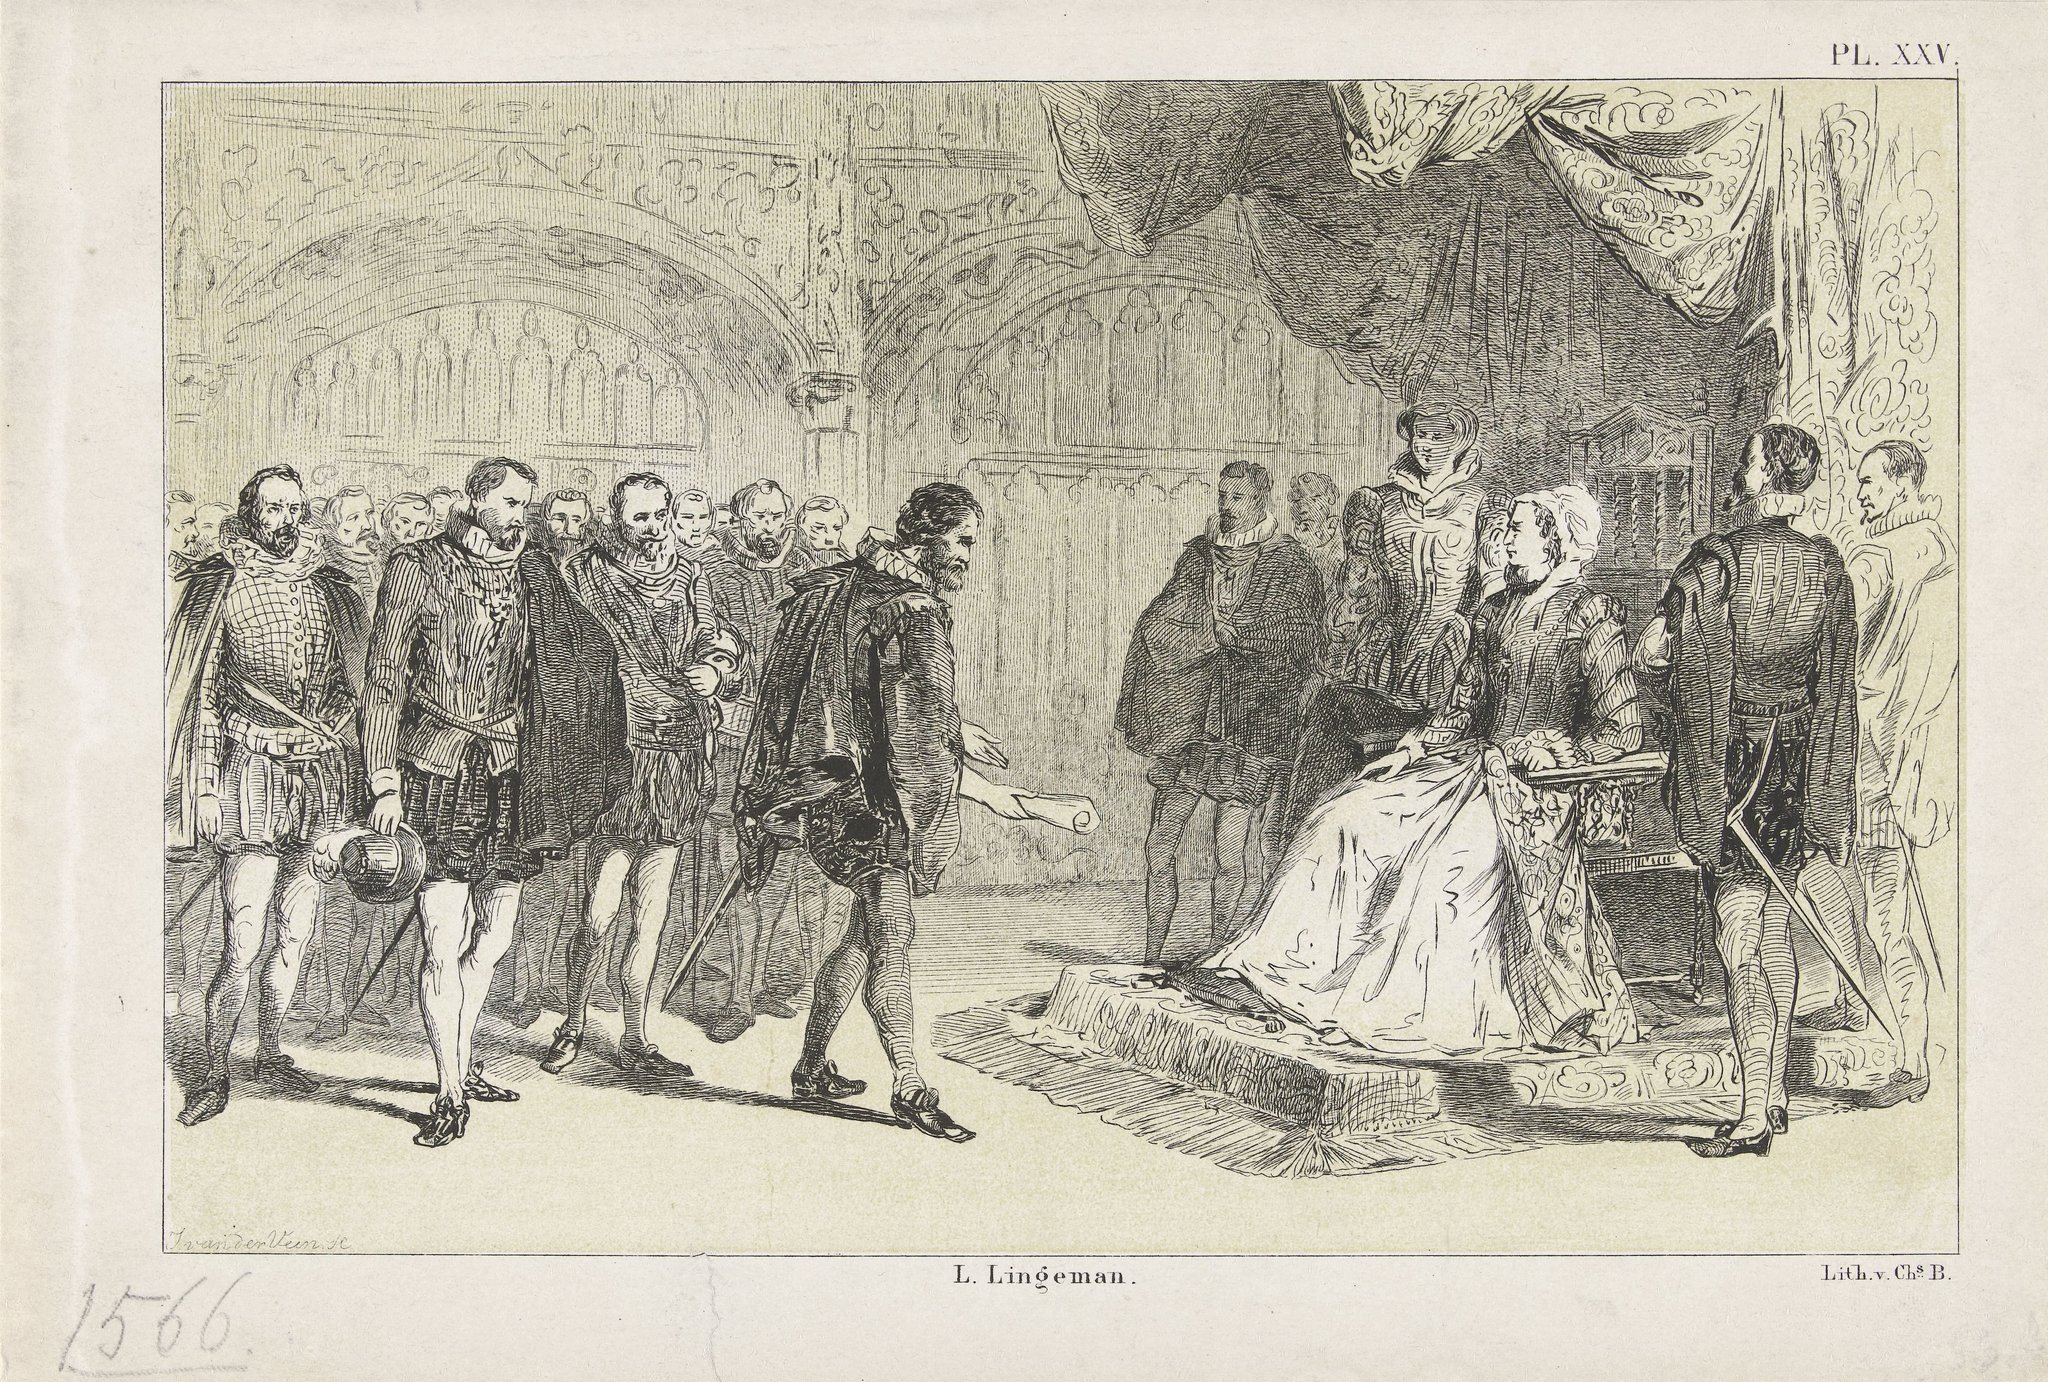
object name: print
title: Het aanbieden van het Smeekschrift aan de hertogin van Parma, 1566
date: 1853-1860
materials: paper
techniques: lithograph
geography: netherlands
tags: brussels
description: Het aanbieden van het Smeekschrift door het verbond der edelen aan de landvoogdes, de hertogin van Parma, te Brussel 5 april 1566. De voorste van de edelen, Hendrik van Brederode, biedt de landvoogdes het Smeekschrift aan. De hertogin zit op haar troon omringd door haar raadgevers.